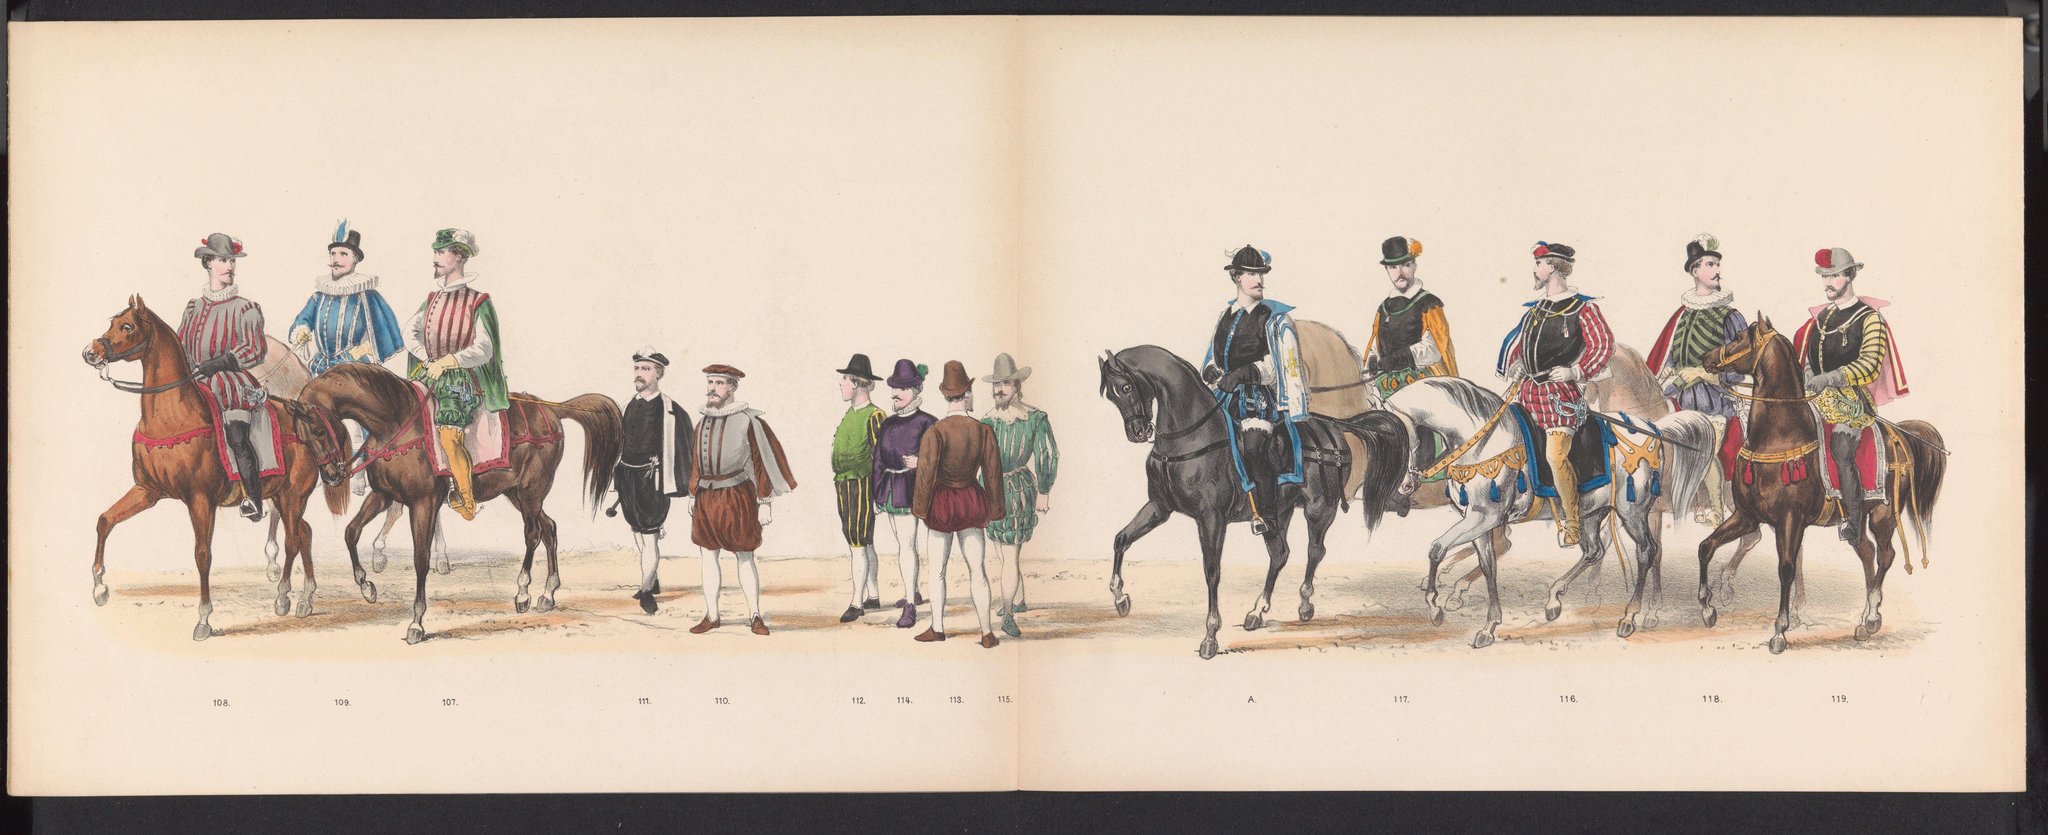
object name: print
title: Gecostumeerde optogt gehouden door de leden van het Leidsche studentencorps den 7den Junij 1870, ter viering van den 295sten verjaardag der Leidsche Hoogeschool, voorstellende bezoek gebragt aan Leiden in 1586, door Robert Lord Dudley, Baron van Denbigh, Graaf van Leicester, enz. enz.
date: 1870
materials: paper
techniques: hand coloring, lithograph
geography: netherlands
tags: robert dudley (1st earl of leicester), students' pageant, costumes used in pageants, leiden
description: Historische gekostumeerde optocht van de studenten van de Leidse Hogeschool gehouden op 7 juni 1870 ter gelegenheid van het 295-jarig bestaan van de Hogeschool. De optocht verbeeldt de intocht van de Graaf van Leicester in Leiden in 1586. Negende plaat met de groepen genummerd 108-119. Onderdeel van de serie van 18 aaneen geplakte bladen.